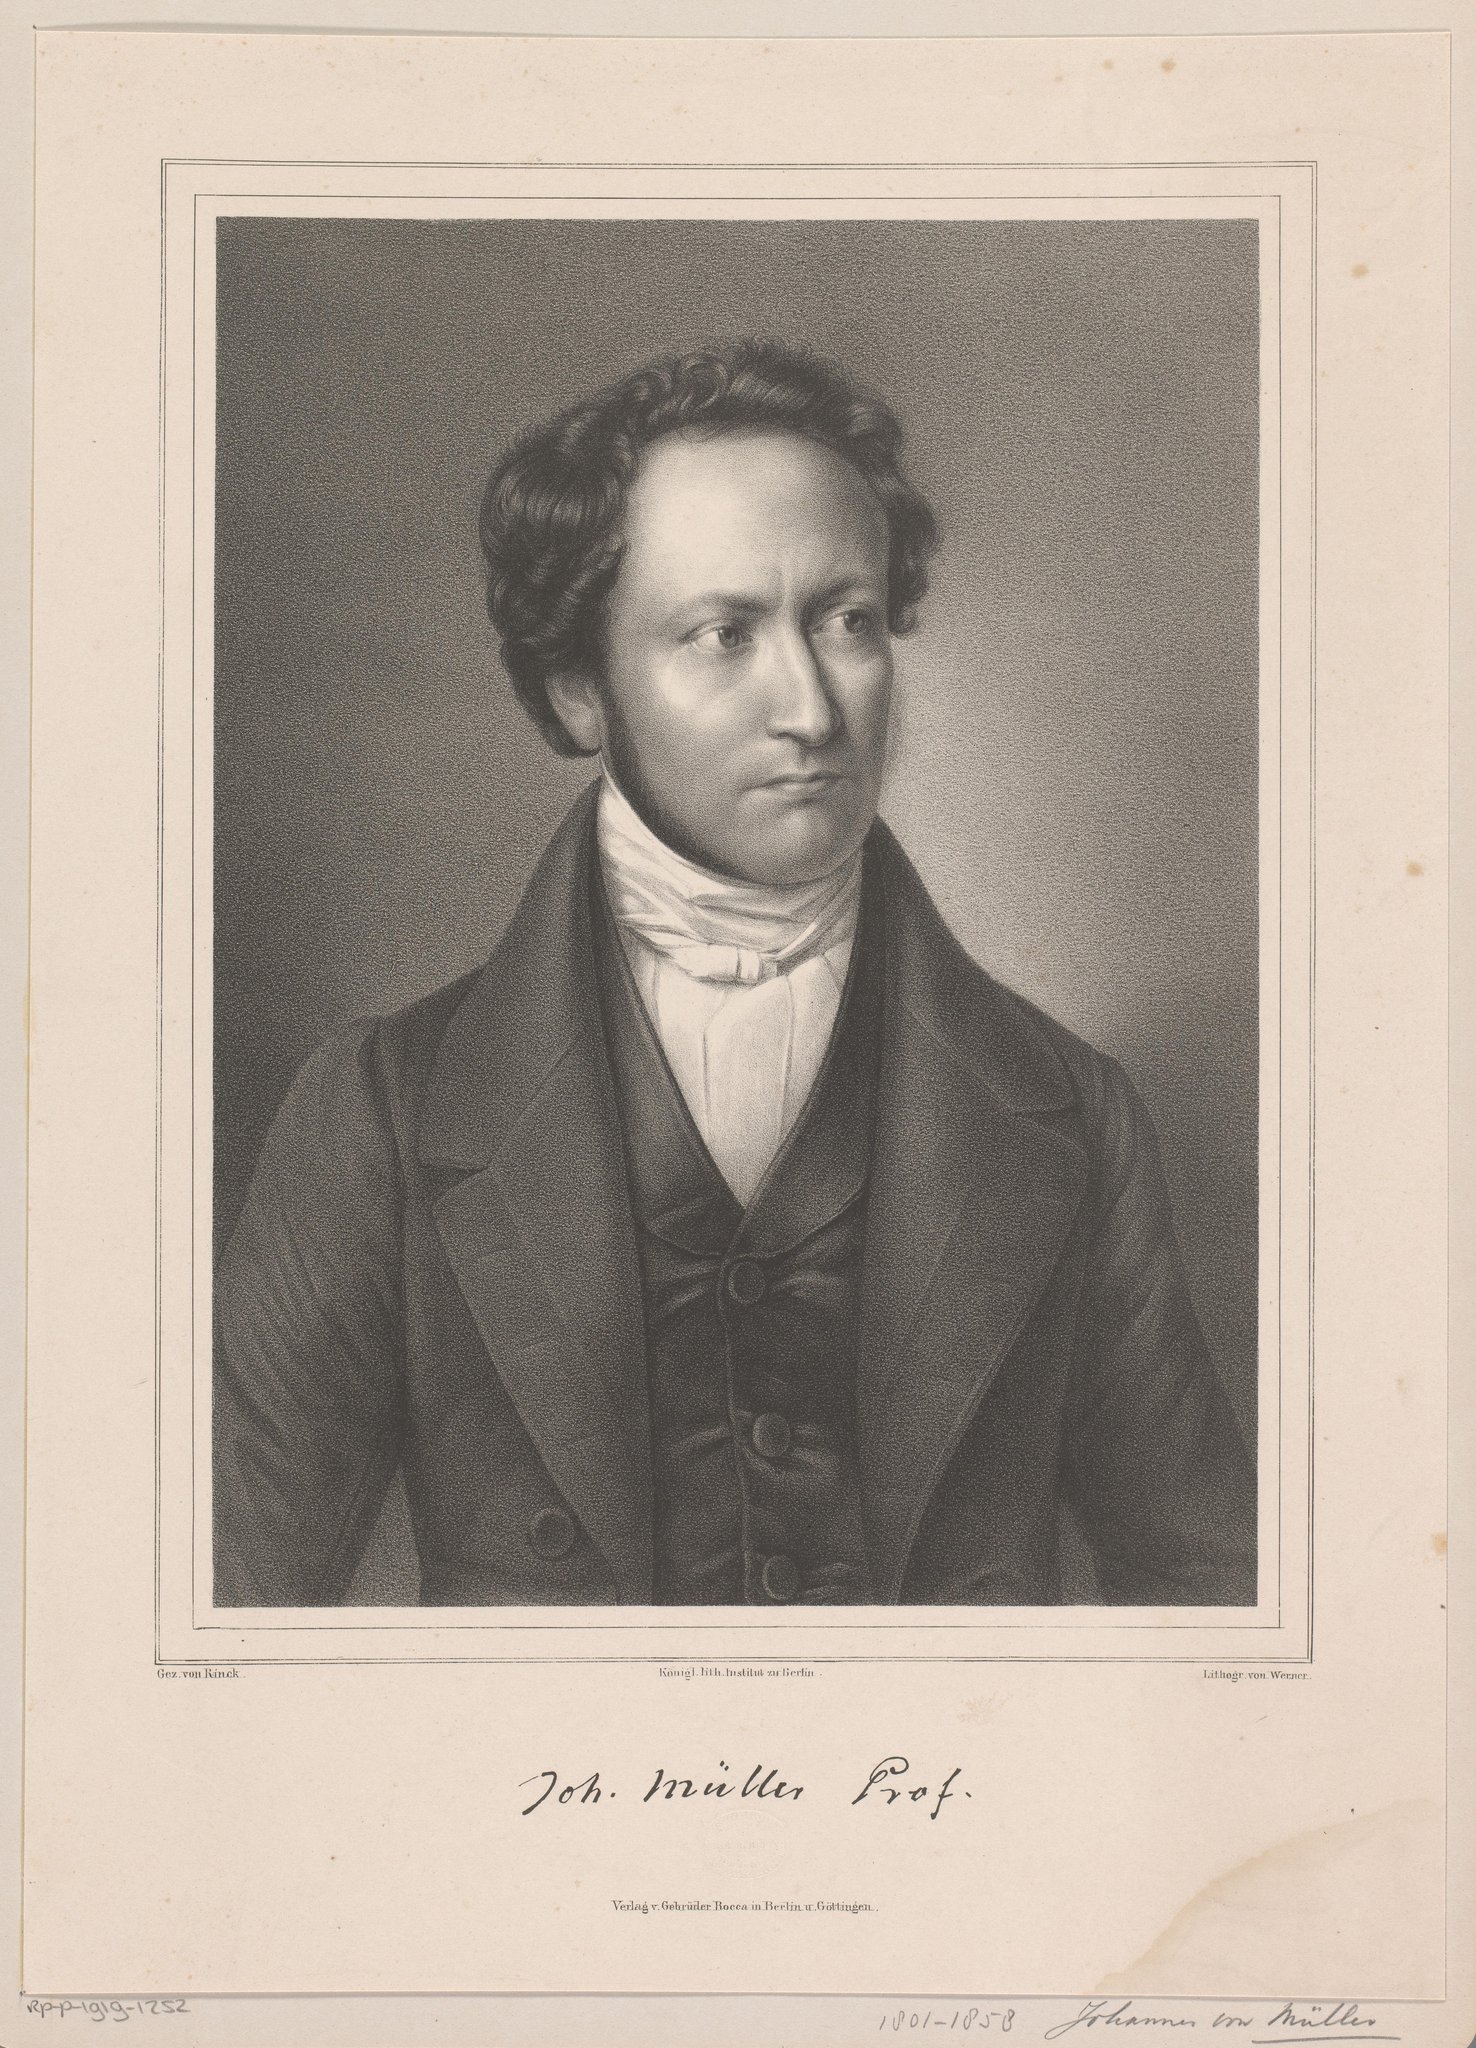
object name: print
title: Portret van Johannes Peter Müller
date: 1830-1855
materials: paper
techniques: lithograph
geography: gottingen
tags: adult man, historical persons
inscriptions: collector's mark: Lugt 2228, collector's mark: Lugt 5514